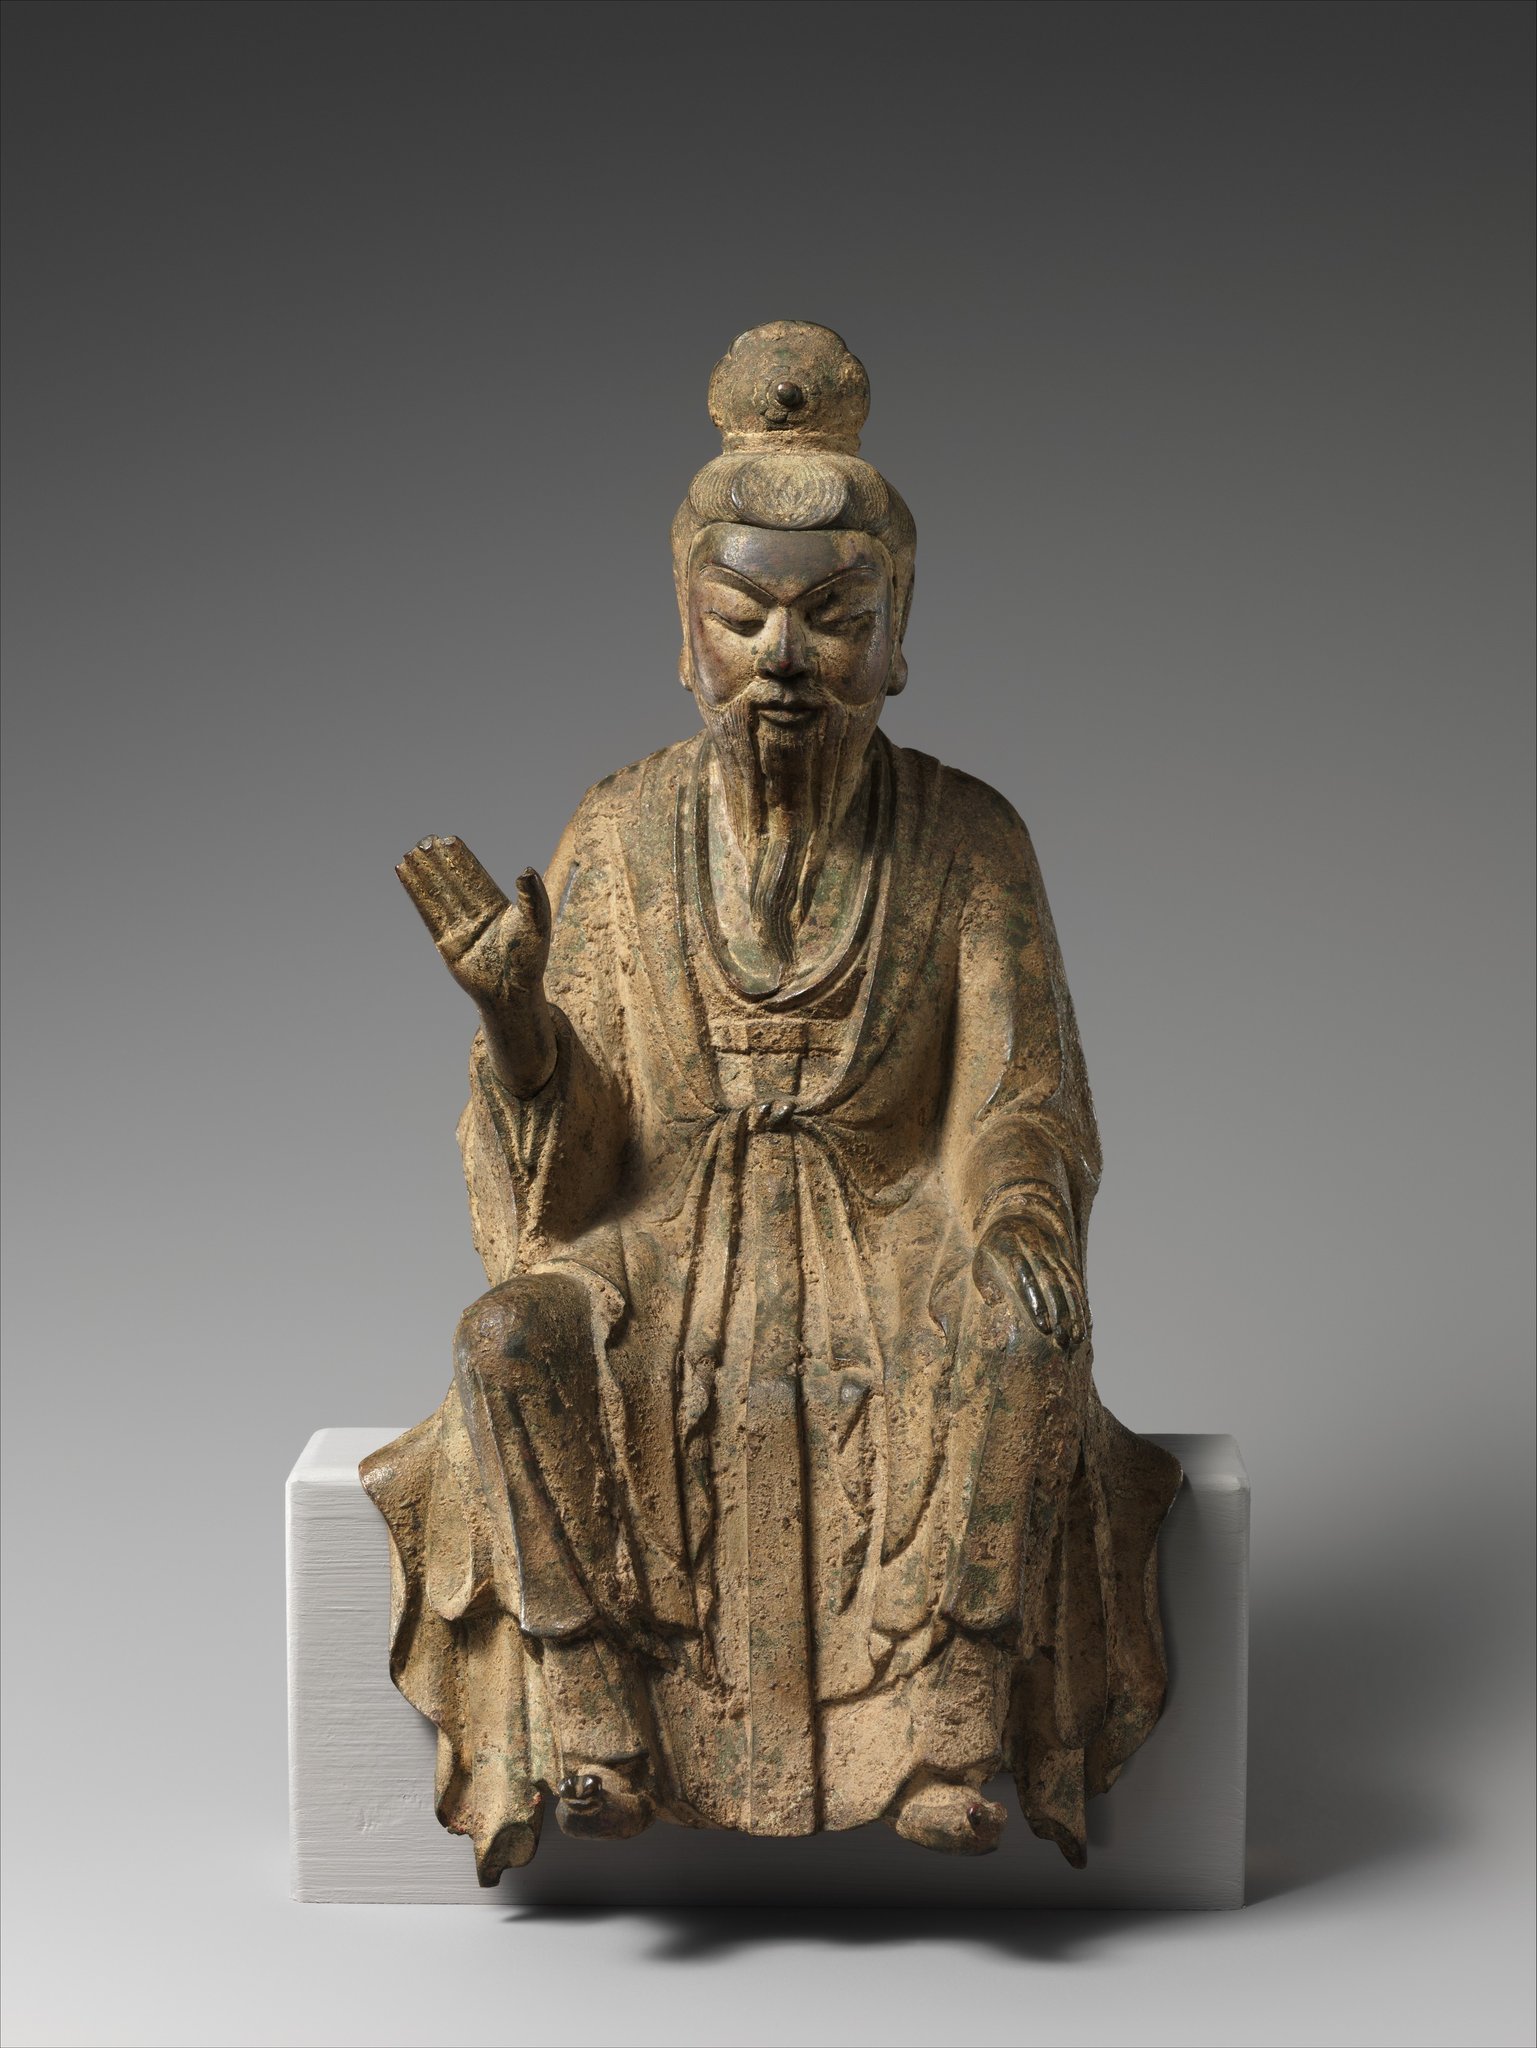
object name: figure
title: Daoist Immortal, probably Laozi (老子)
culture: chinese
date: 901-1000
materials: bronze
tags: men,monks